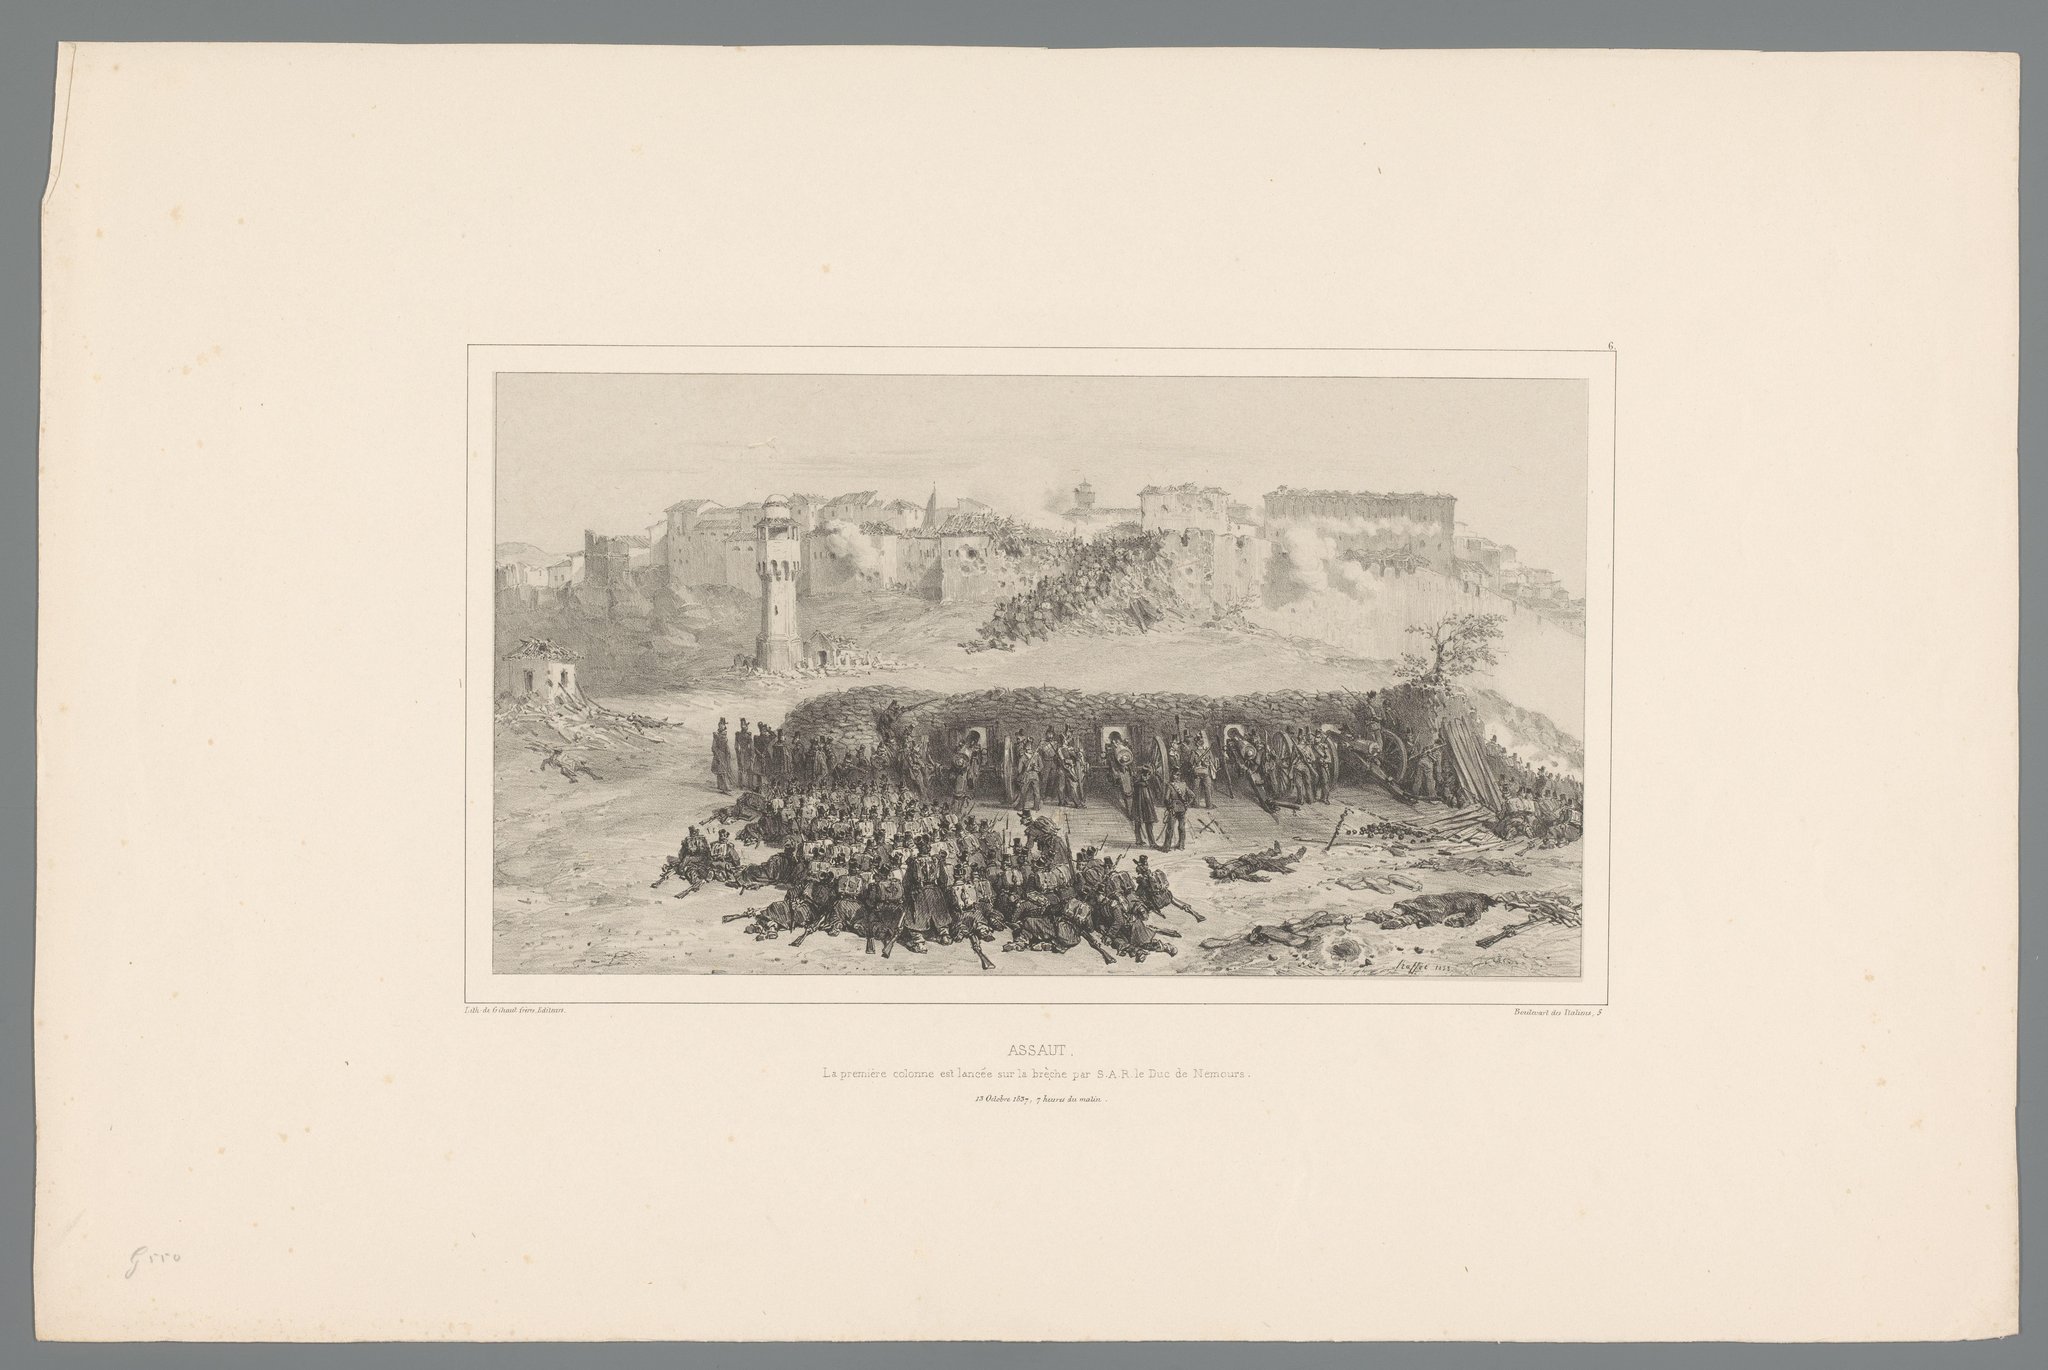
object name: print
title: Assaut (...) 13 octobre 1837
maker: denis auguste marie raffet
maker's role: draughtsman, print maker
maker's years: 1804-1860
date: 1838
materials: paper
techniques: lithograph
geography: paris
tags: firearms: cannon, (military) attack, the soldier; the soldier's life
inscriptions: collector's mark: Lugt 2228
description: Op de voorgrond de verdedigingslinie van de Fransen.